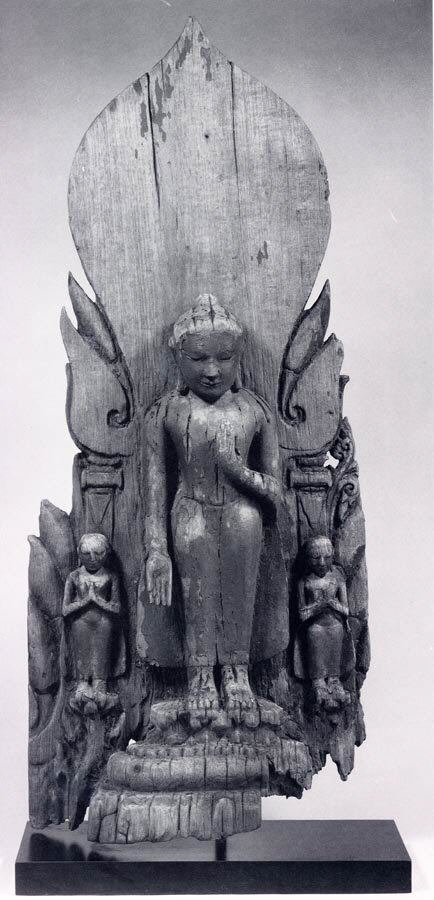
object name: sculpture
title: Standing Buddha Flanked by Disciples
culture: burmese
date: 1201-1250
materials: lacquer, wood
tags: buddhism,buddha